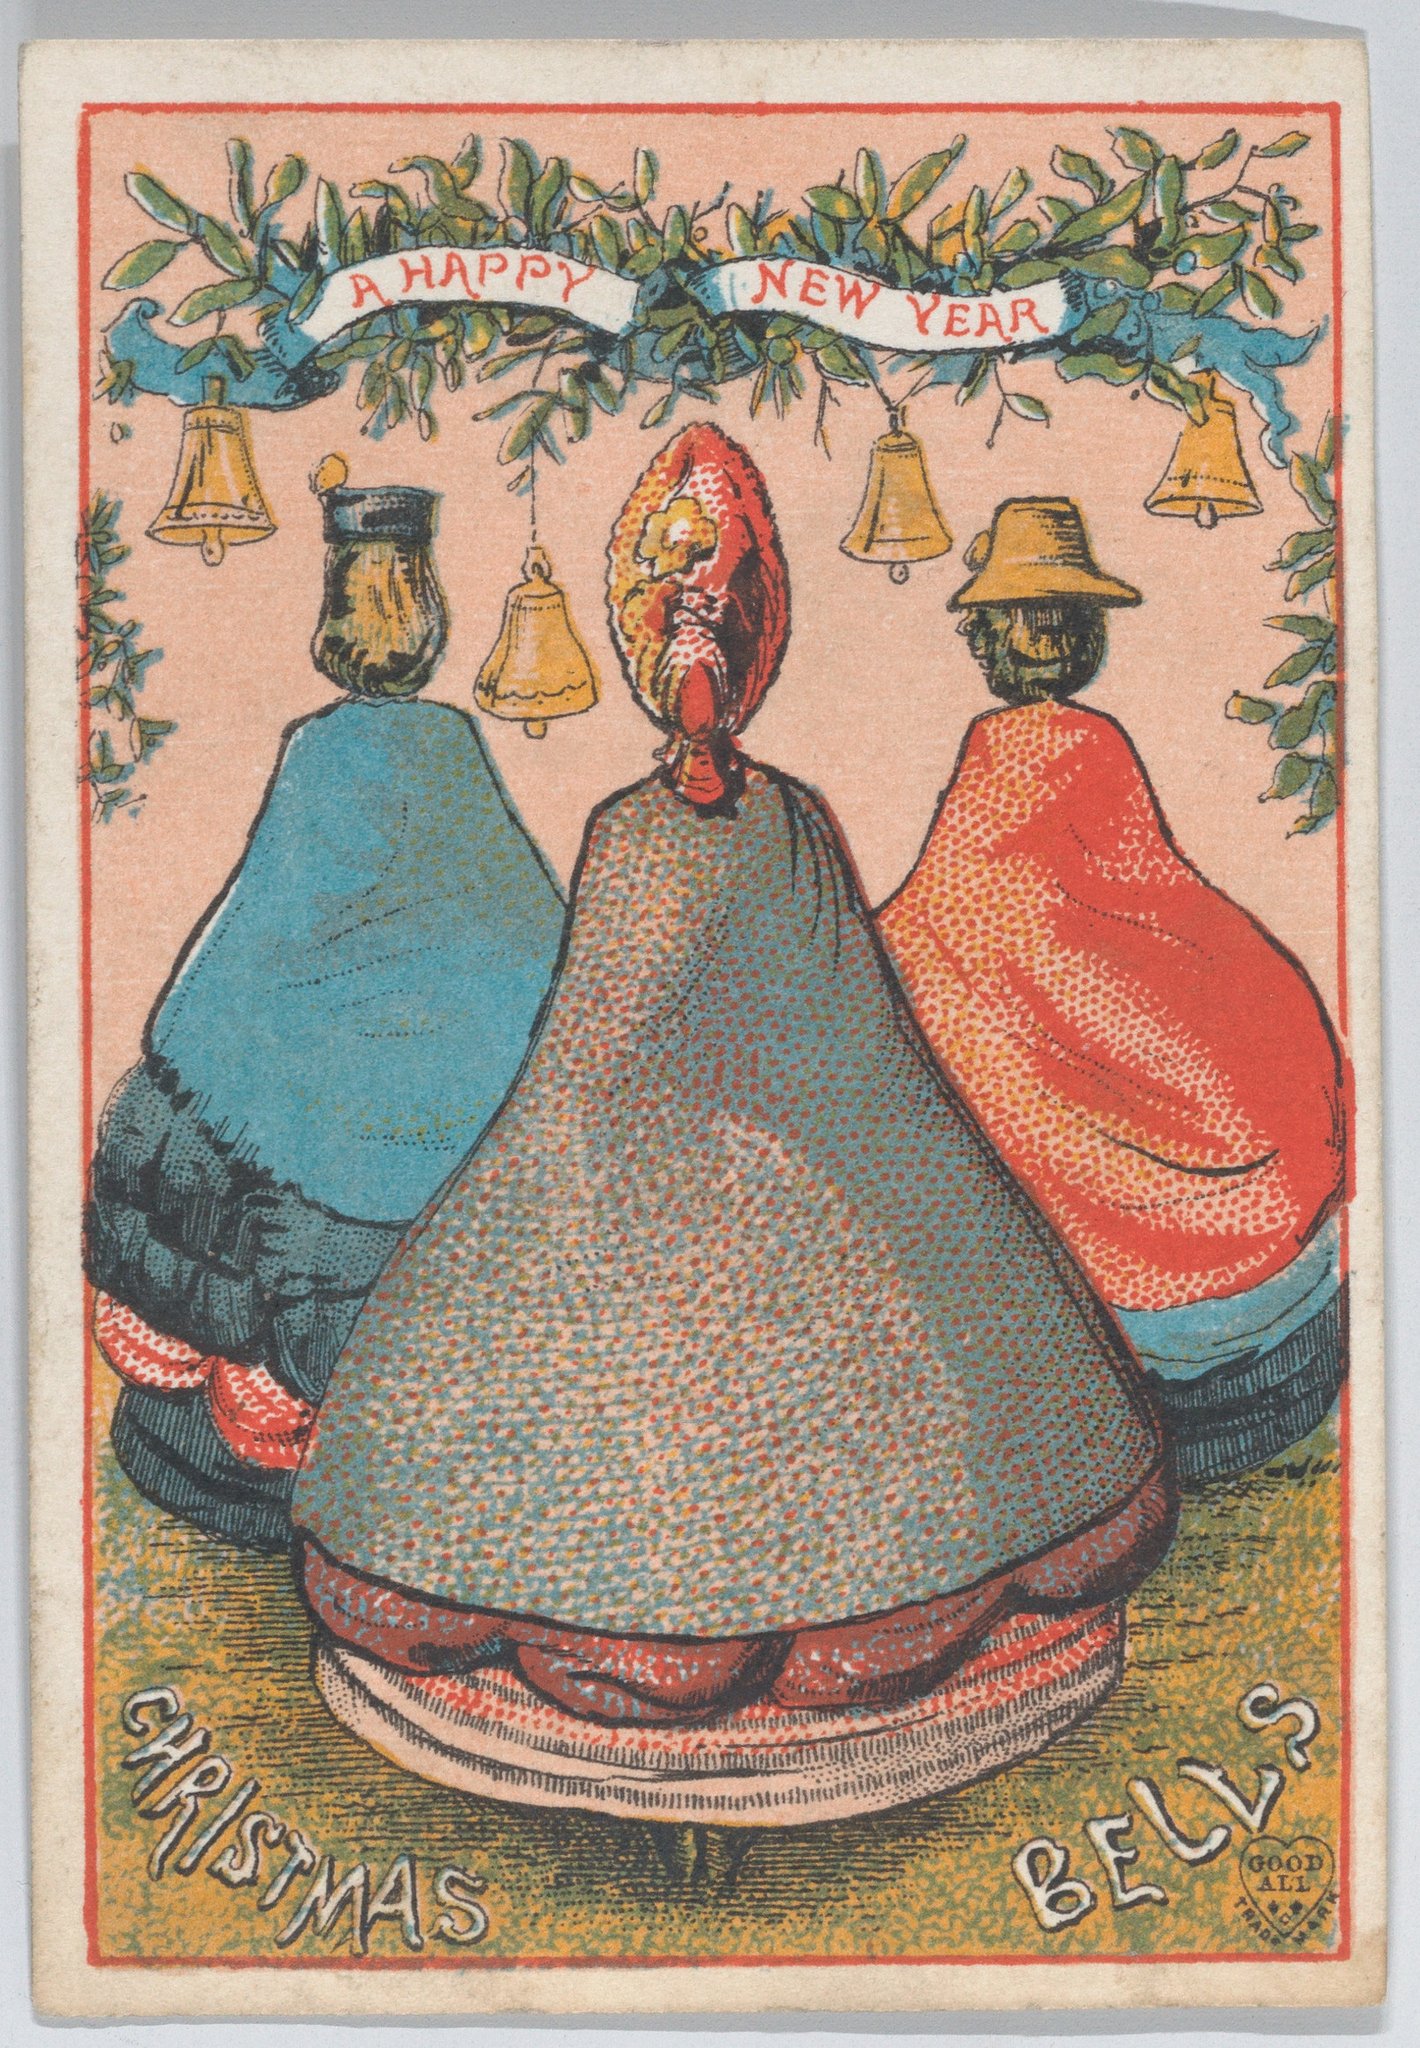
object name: valentine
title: Greeting Card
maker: charles henry bennett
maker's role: artist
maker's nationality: british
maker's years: 1828-1867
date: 1866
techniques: chromolithography